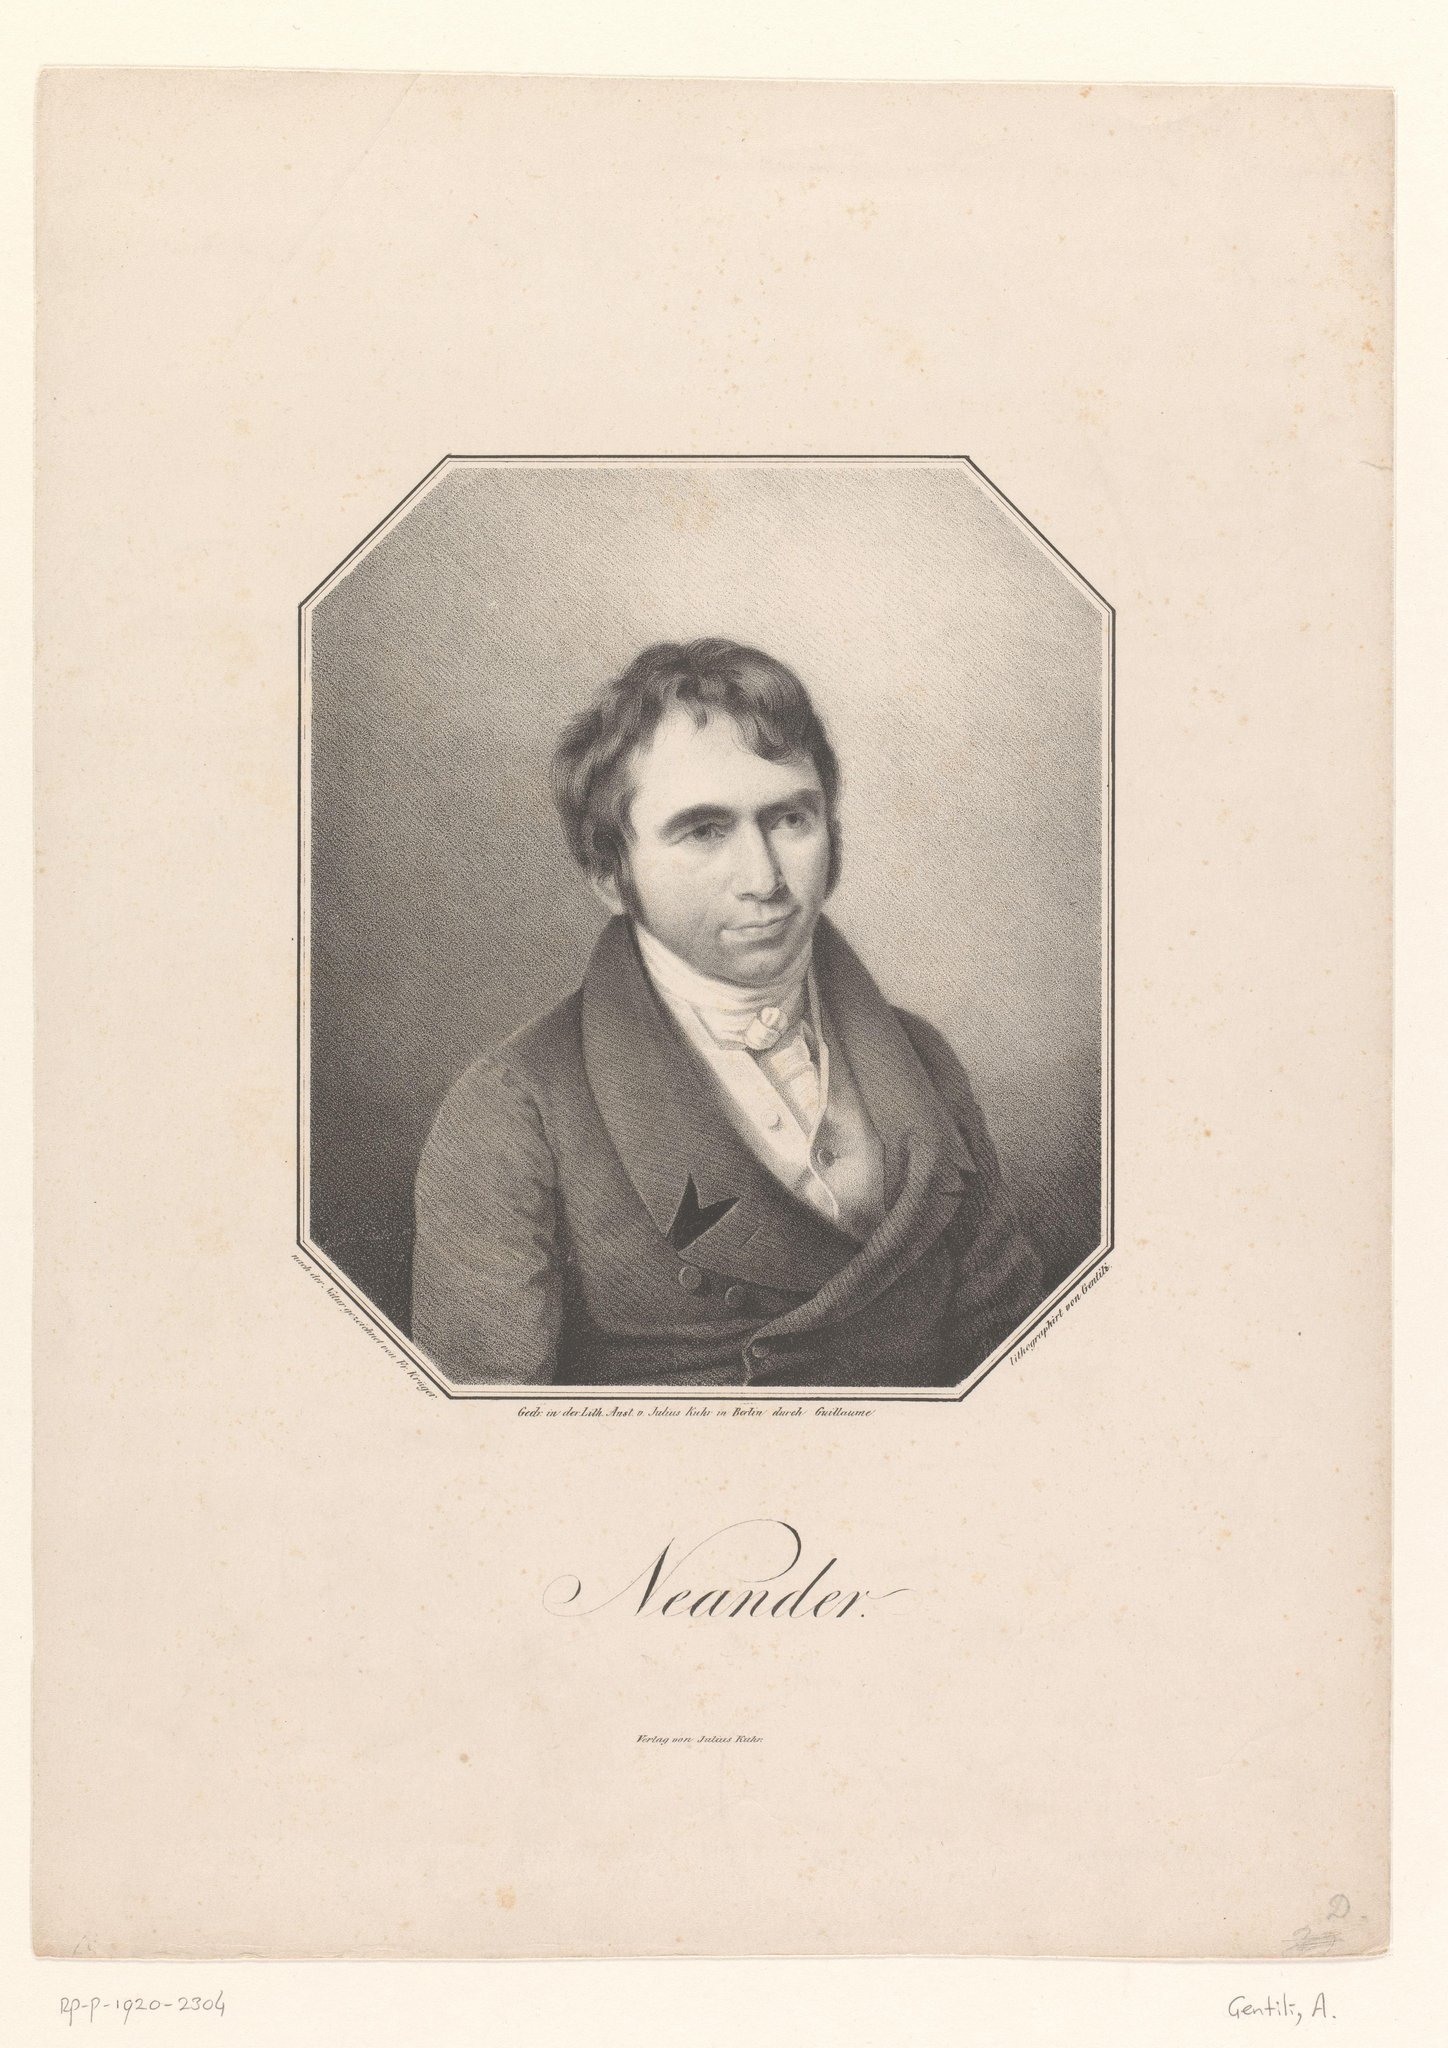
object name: print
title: Portret van August Neander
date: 1826-1840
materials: paper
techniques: lithograph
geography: berlin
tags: berlin, theologian, historical persons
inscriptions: inscription: ‘in Franken aanwezig/ Gm’, collector's mark: Lugt 2228